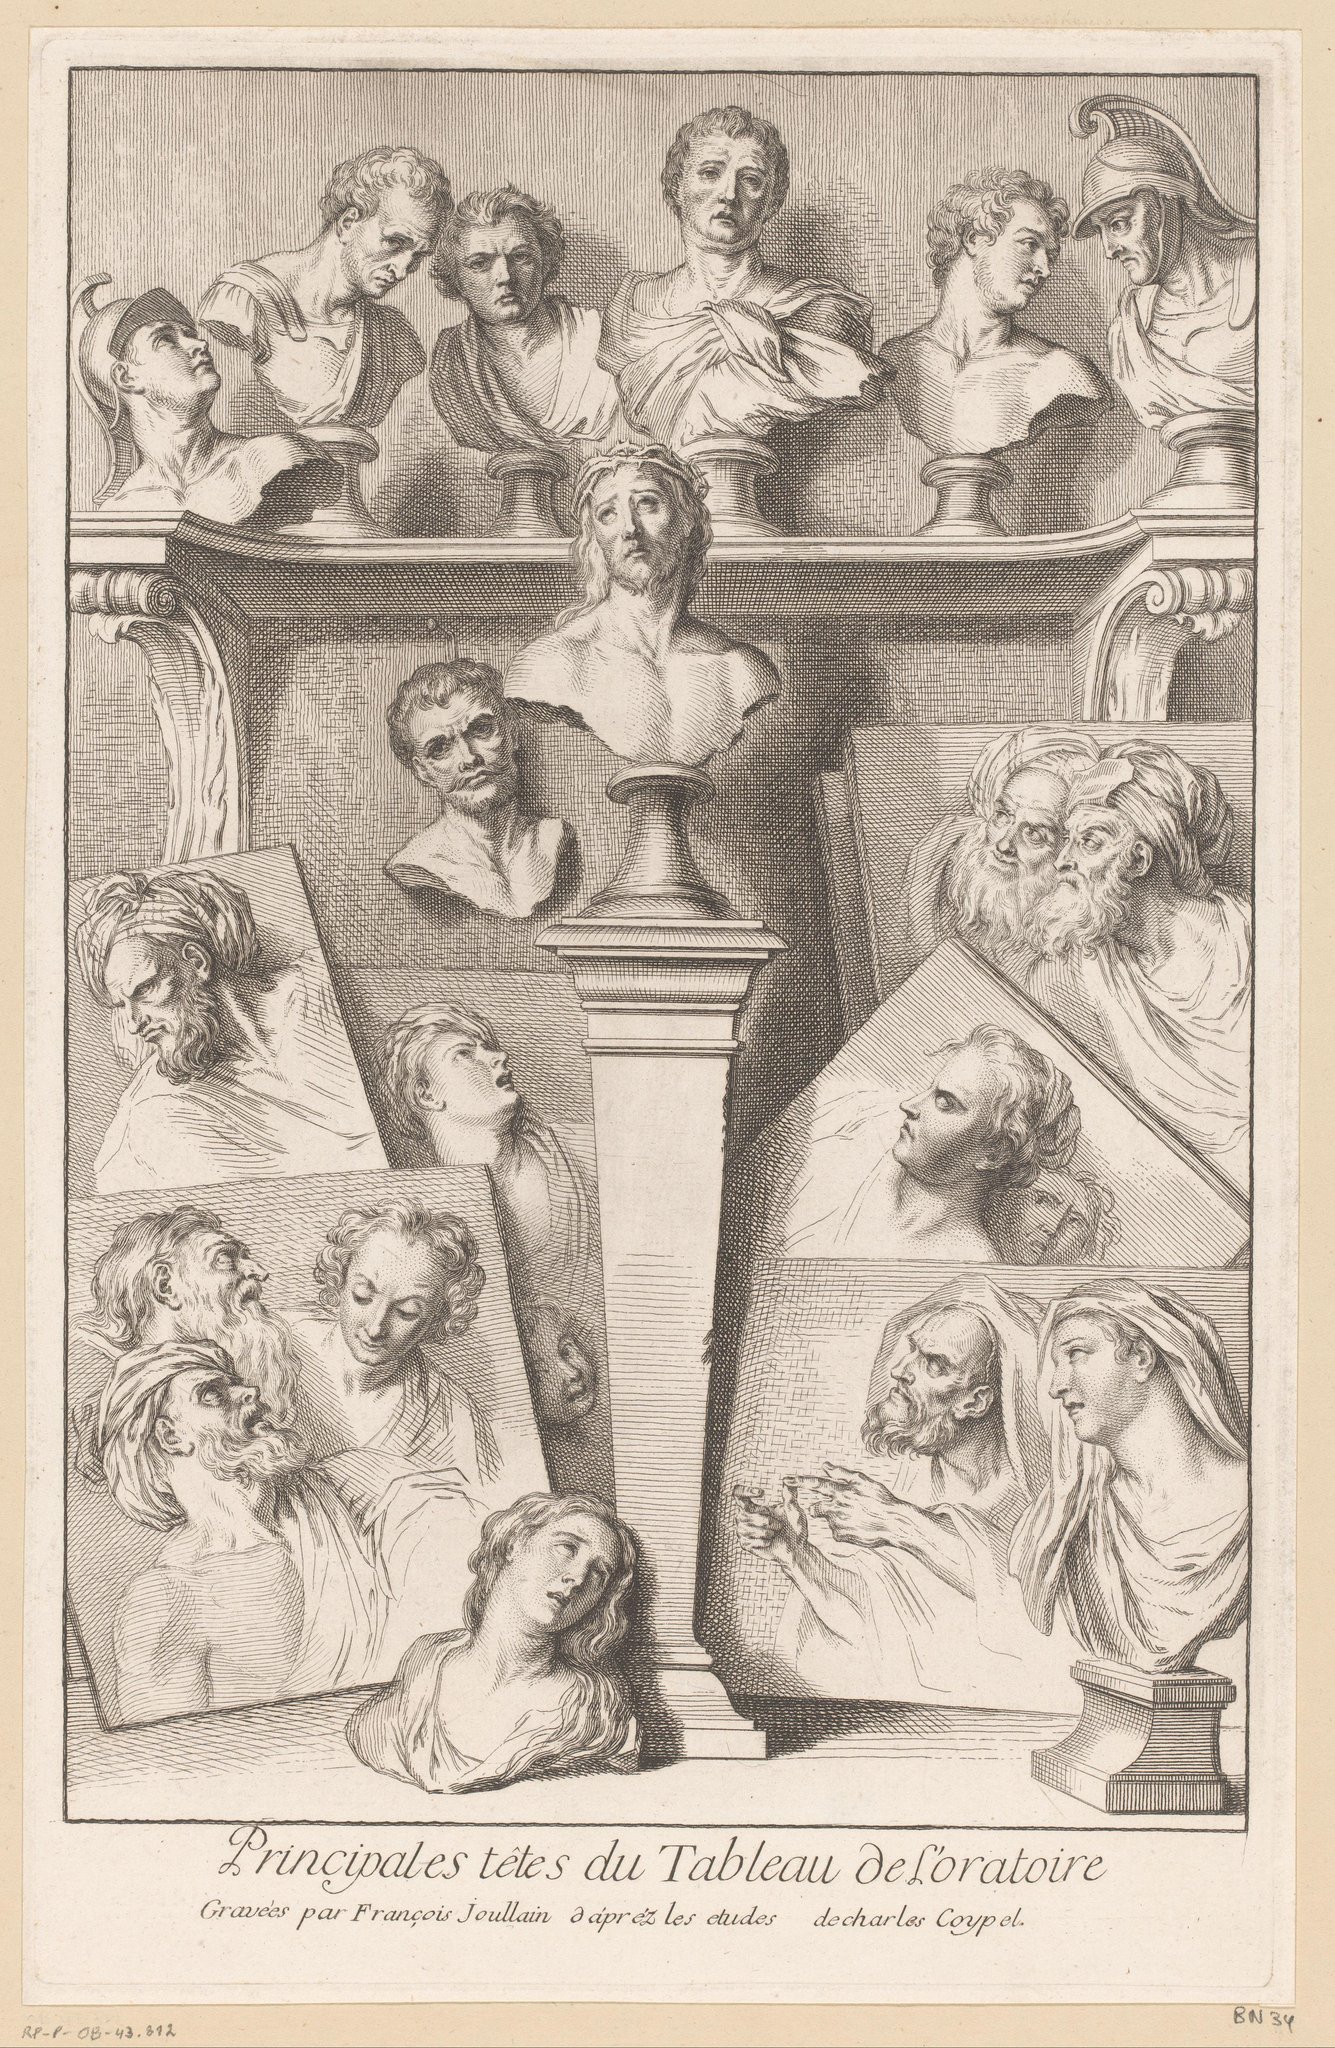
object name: print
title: Pricipales têtes du Tableau de l'oratoire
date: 1729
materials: paper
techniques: engraving, etching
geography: france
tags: head of christ with crown of thorns, sculpture, picture, painting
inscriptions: collector's mark: Lugt 240